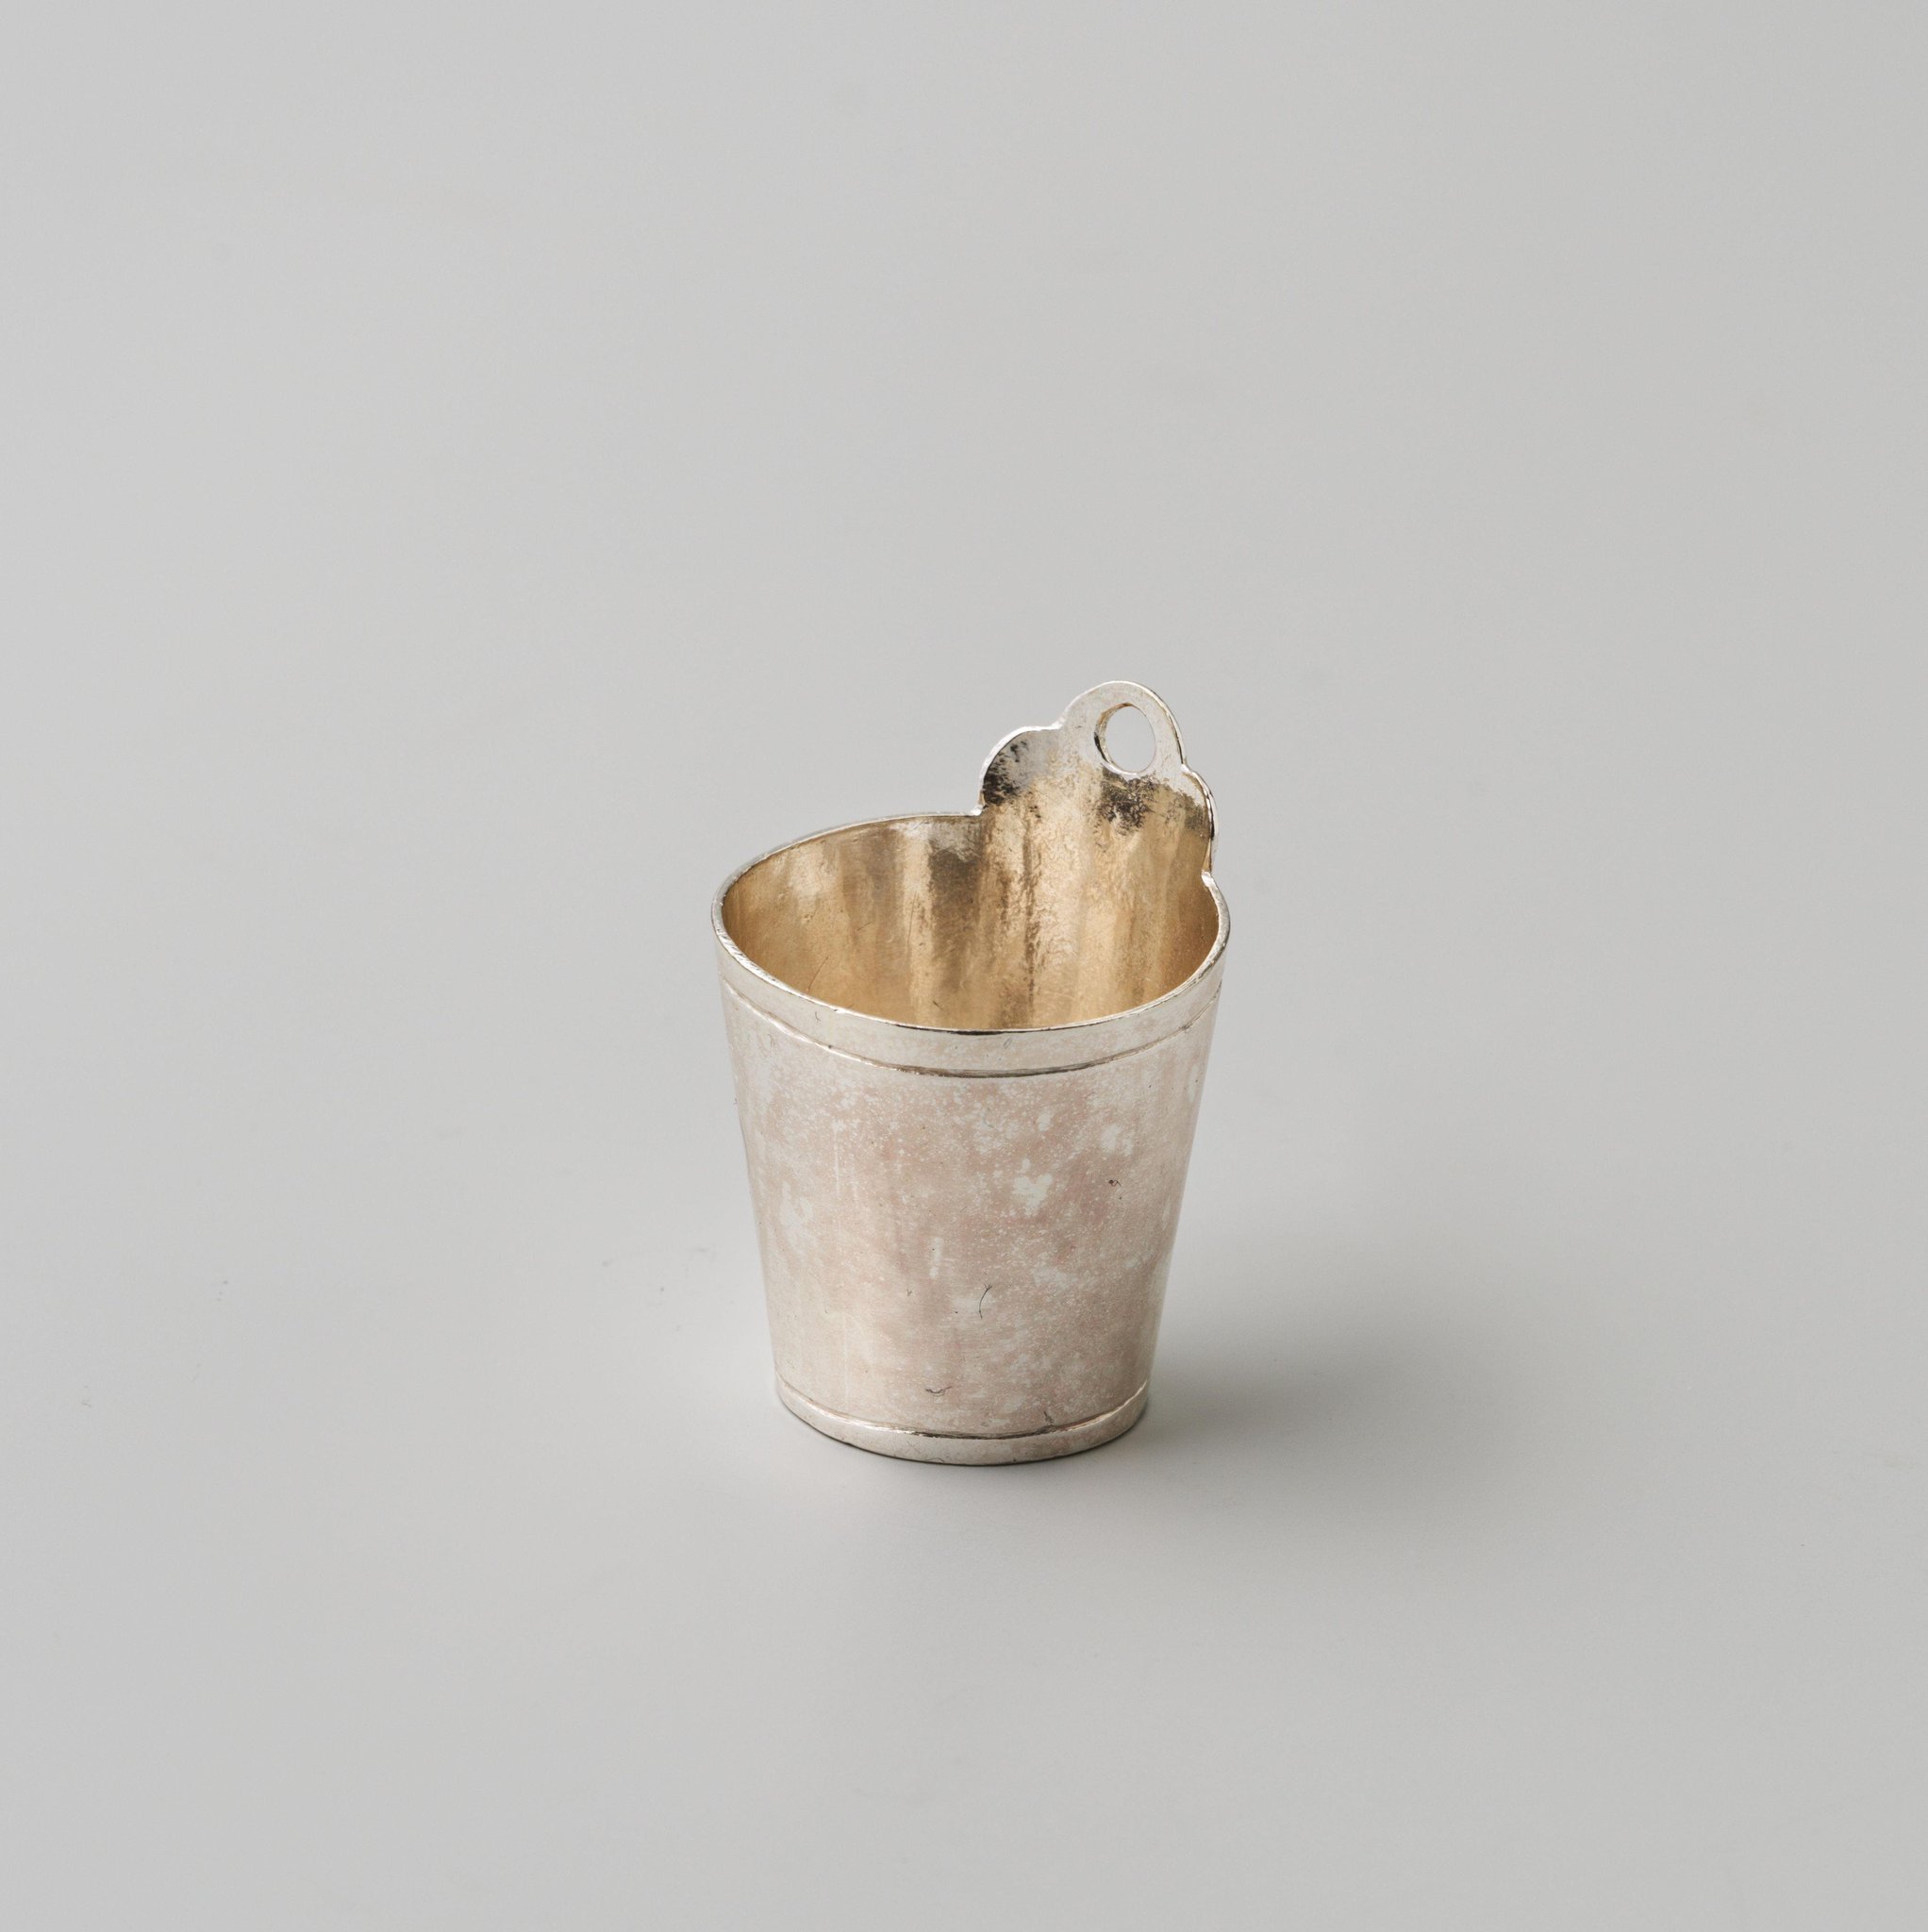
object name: miniature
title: Zeepbak van zilver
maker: abraham van der hoeff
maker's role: silversmith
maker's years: 1686-1735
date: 1735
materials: silver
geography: haarlem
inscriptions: date letter: ‘A (=1735)’, maker's mark: ‘Hert (Voet 88, Citroen, 118)’, town mark: ‘Haarlem’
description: Zeepbak van zilver, rond met draagoog, versierd met twee groeflijnen.